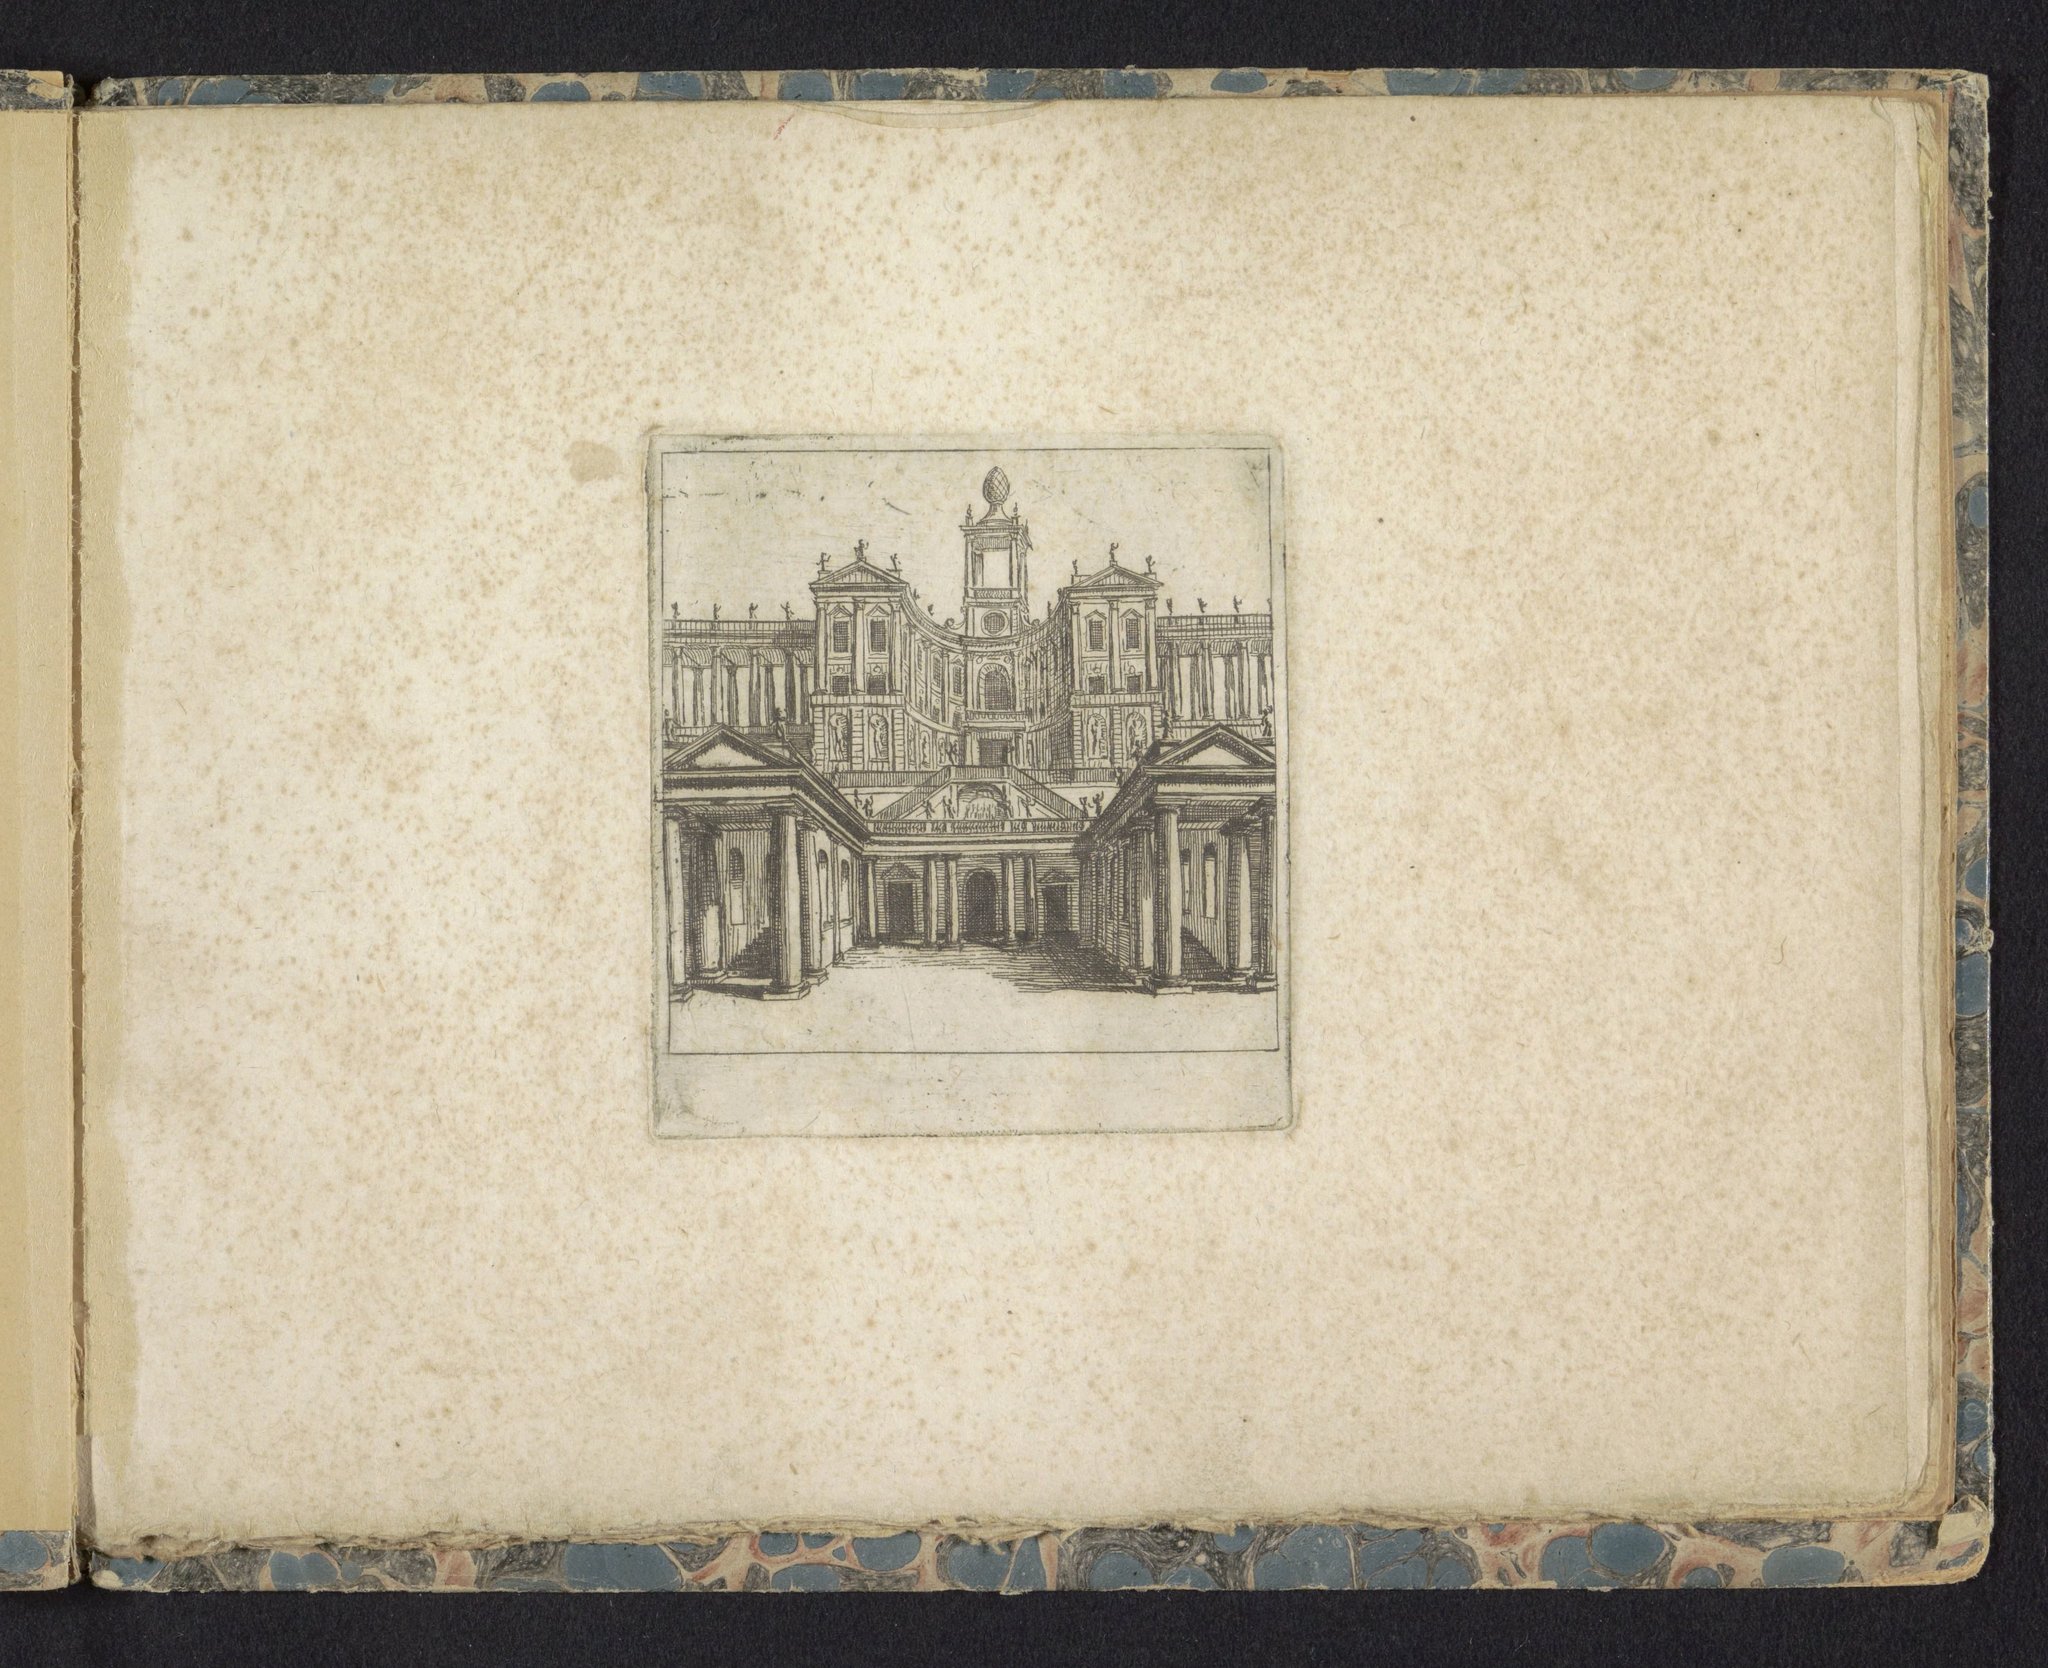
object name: album leaf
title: Decorontwerp met een paleis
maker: Anonymous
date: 1750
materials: paper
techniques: etching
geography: italy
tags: set, scenery ~ stage, palace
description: Deze prent maakt deel uit van een reeks van ten minste dertien prenten met decorontwerpen.